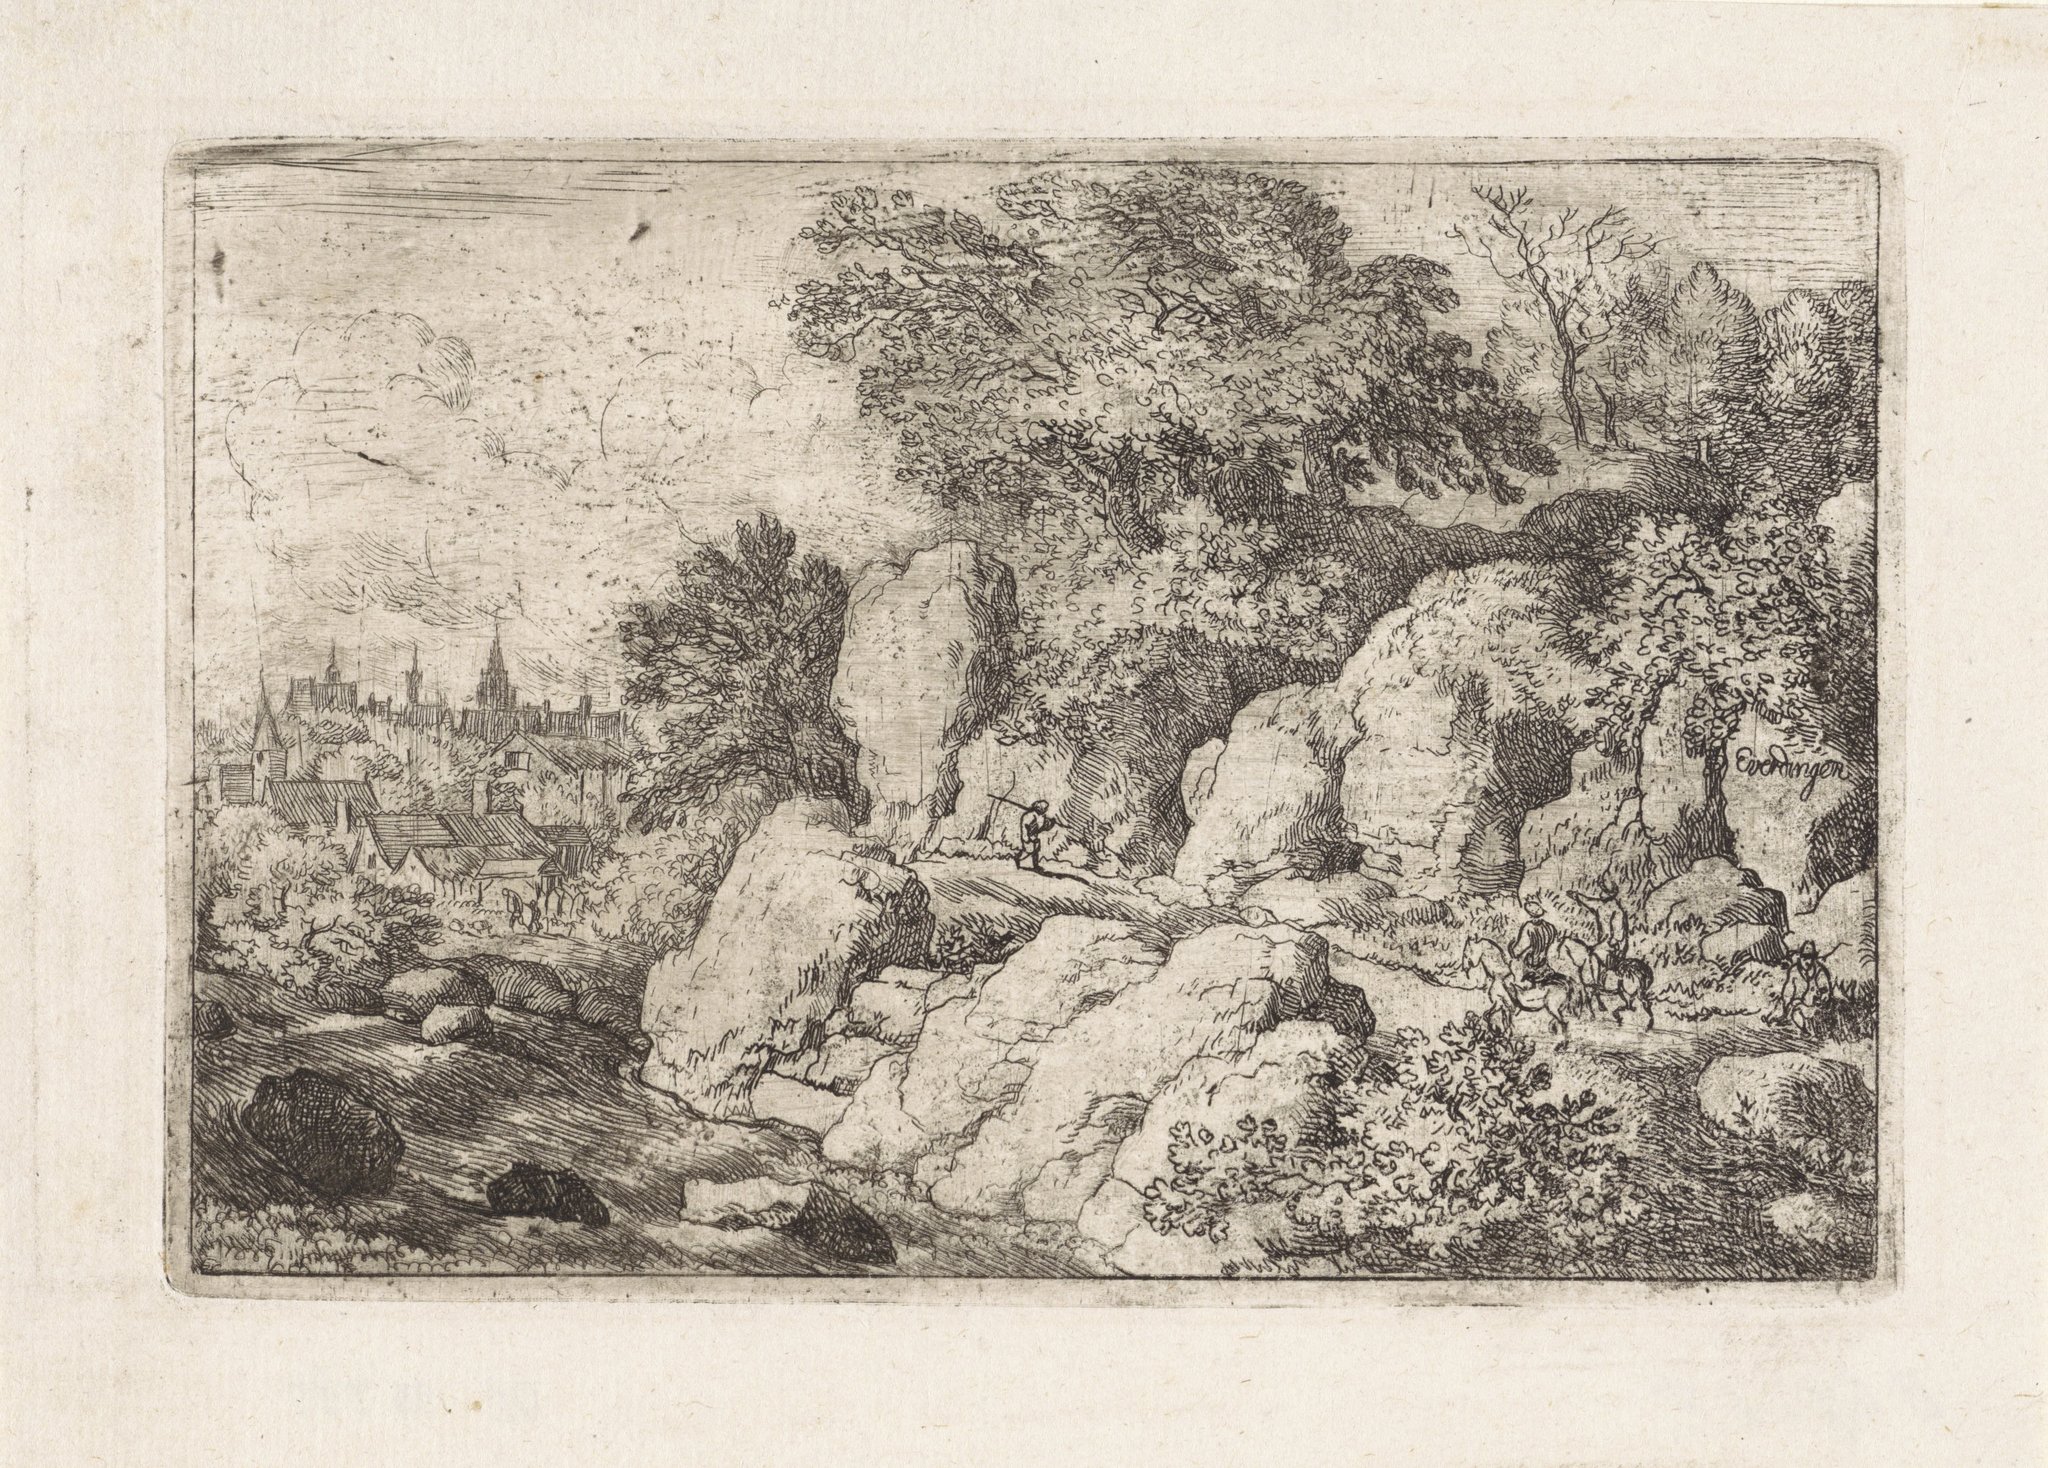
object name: print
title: Landschap met twee ruiters op een rotspad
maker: allaert van everdingen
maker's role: draughtsman, painter, print maker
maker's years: 1621-1675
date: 1631-1675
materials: paper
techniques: etching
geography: netherlands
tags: mountains (+ landscape with figures, staffage)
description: Berglandschap met een stad aan een snelstromende rivier. Op het bergpad twee personen te paard, een wandelaar en een zittend figuur.